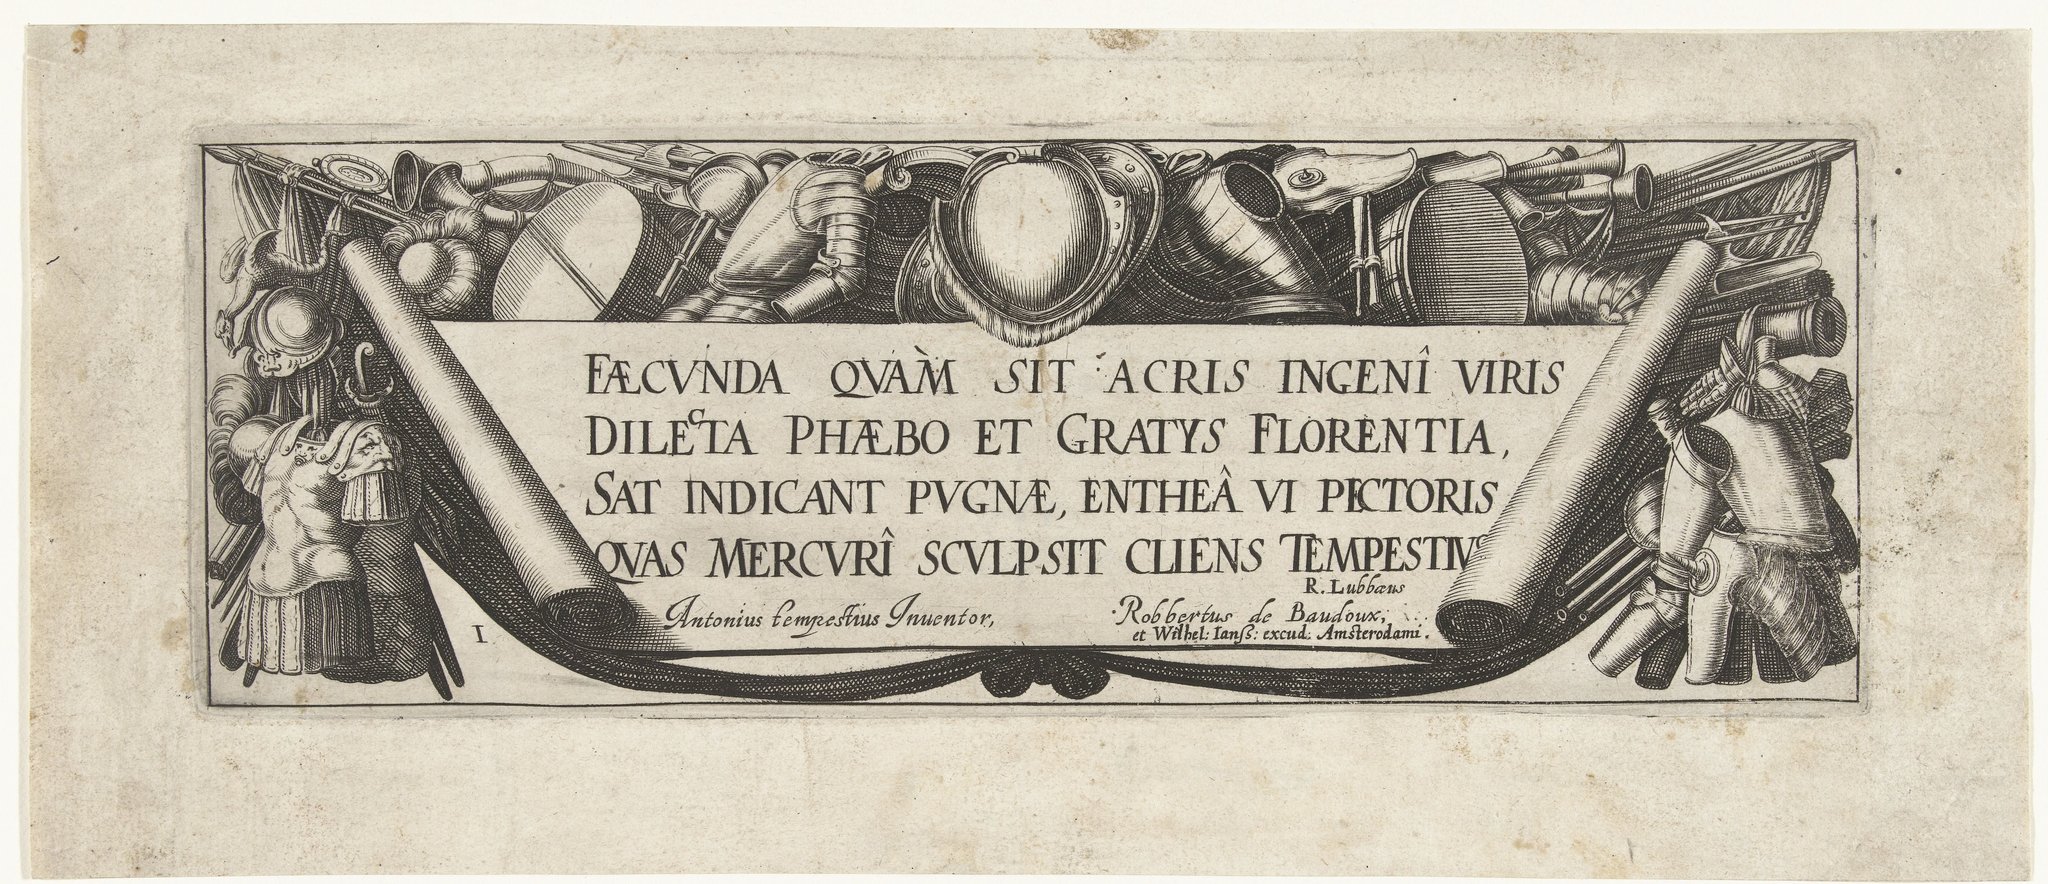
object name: print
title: Titelprent voor een serie prenten met gevechtsscènes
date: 1591-1659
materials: paper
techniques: engraving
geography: amsterdam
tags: weapons, military clothing and other equipment (uniforms, cap, armour, helmet, etc.)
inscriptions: collector's mark: Lugt 2228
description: Titelprent voor een serie prenten met gevechtsscènes naar Antonio Tempesta. Banderol met de titel, eromheen wapenrustingen en wapens.